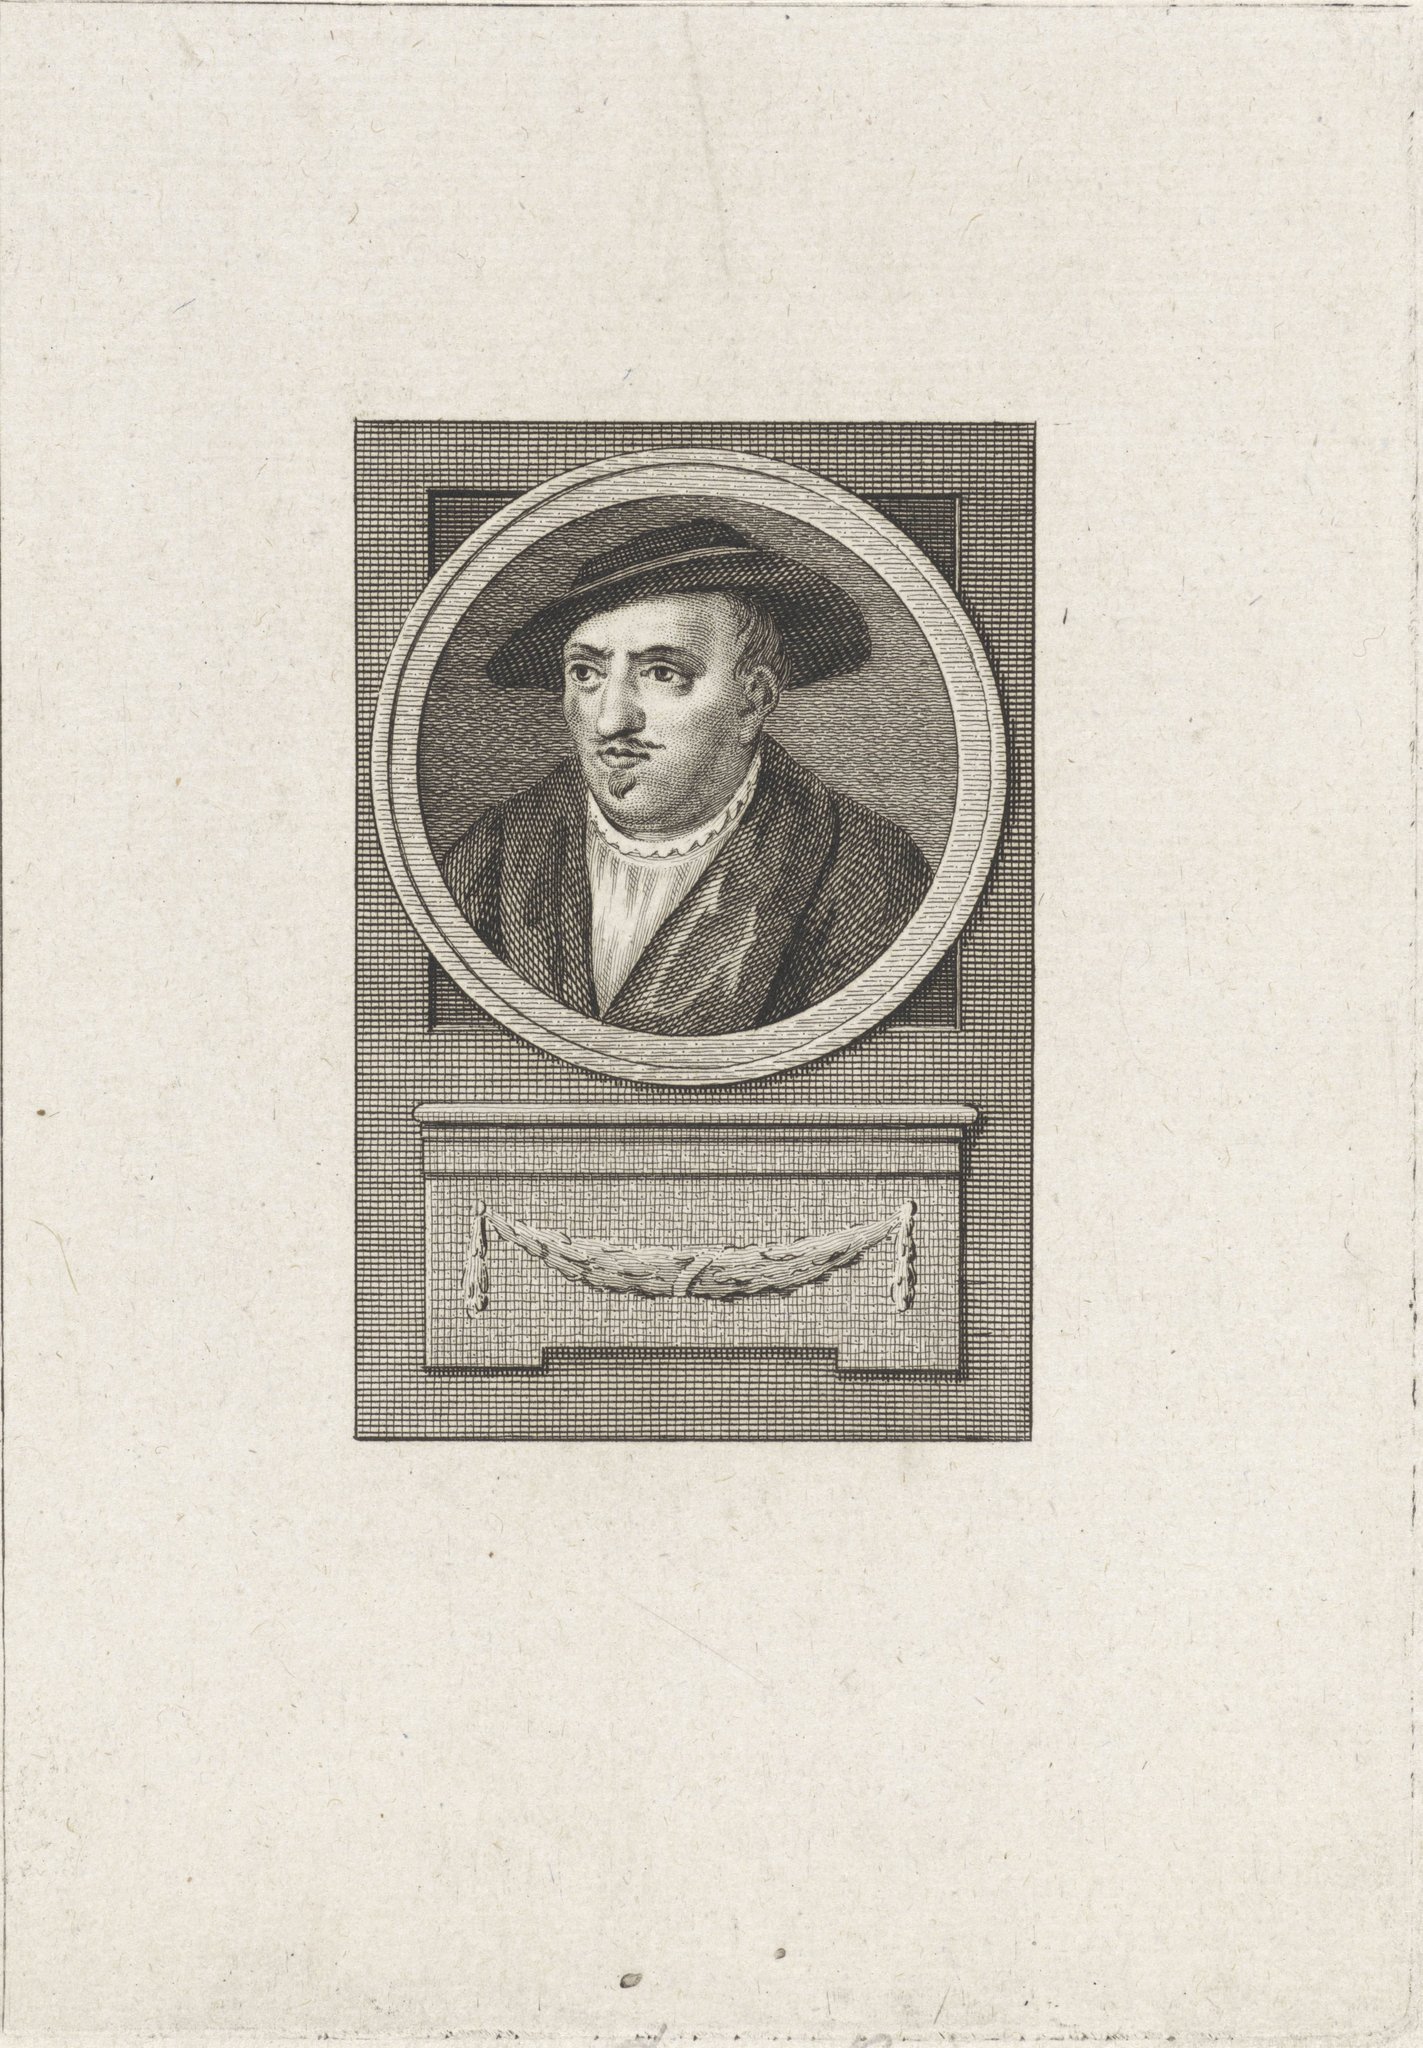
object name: print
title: Portret van Pieter Cornelisz Boom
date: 1783-1795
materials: paper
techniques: engraving, etching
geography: amsterdam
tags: mayor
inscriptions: collector's mark: Lugt 2228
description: Latere staat prent gebruikt in: Fokke, Jan. Geschiedenissen der Vereenigde Nederlanden voor de vaderlandsche jeugd Ie-XXVste deel. Amsterdam: Johannes Allart, 1783-1795. Deel VI.